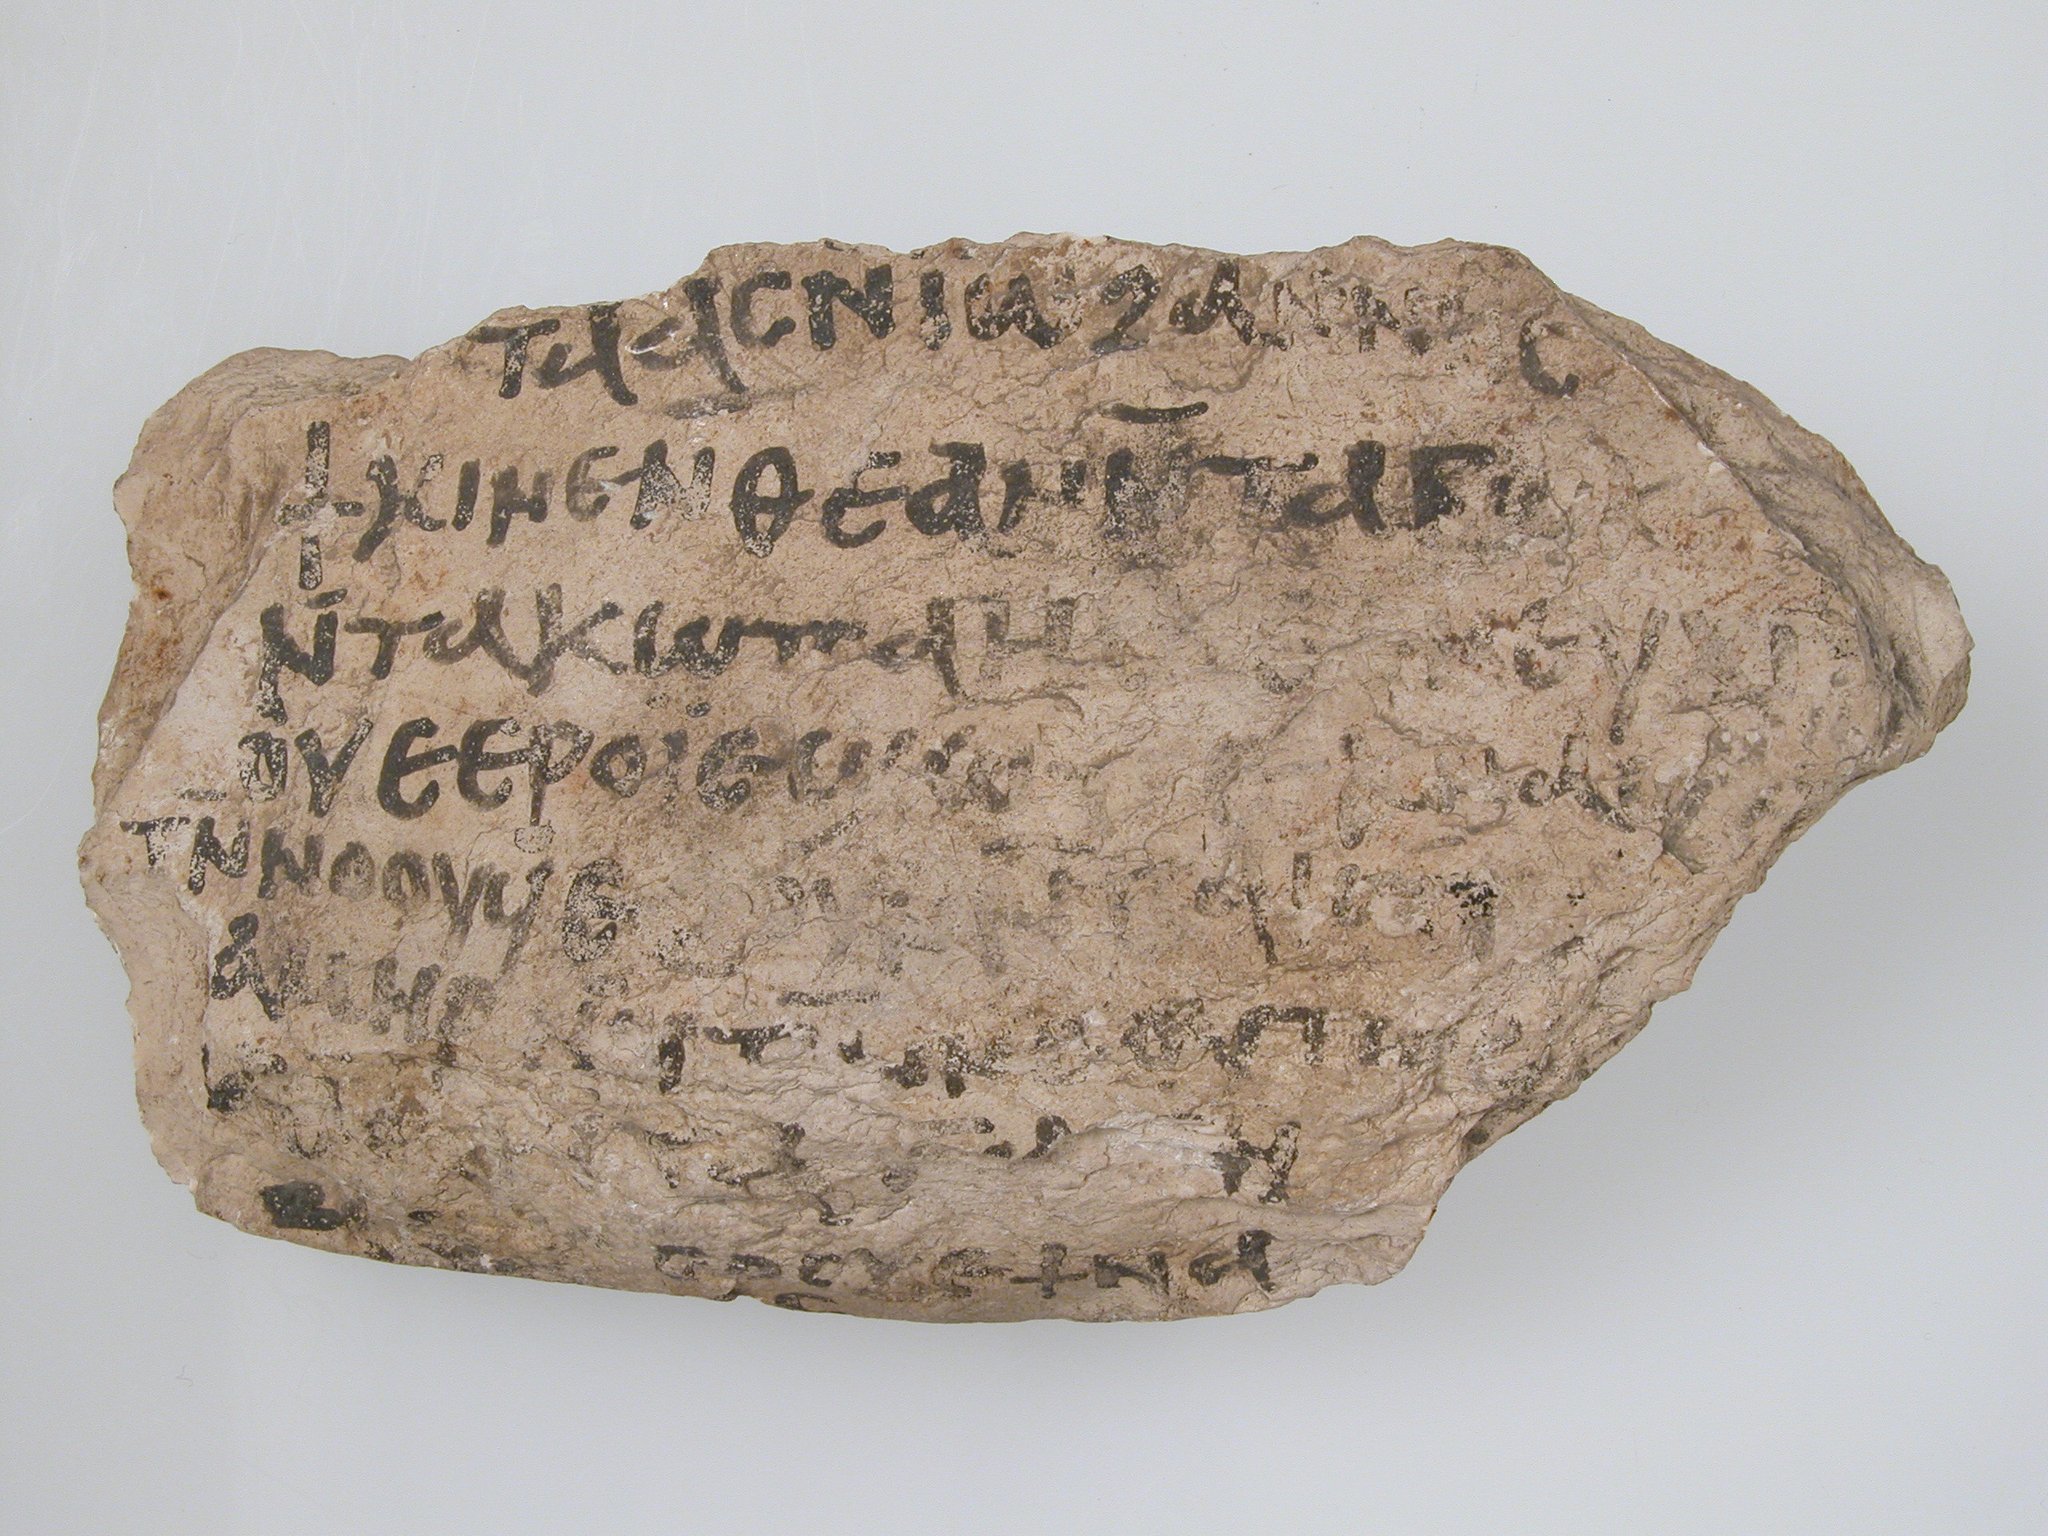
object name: ostrakon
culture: coptic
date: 601-700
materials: ink, limestone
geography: egypt